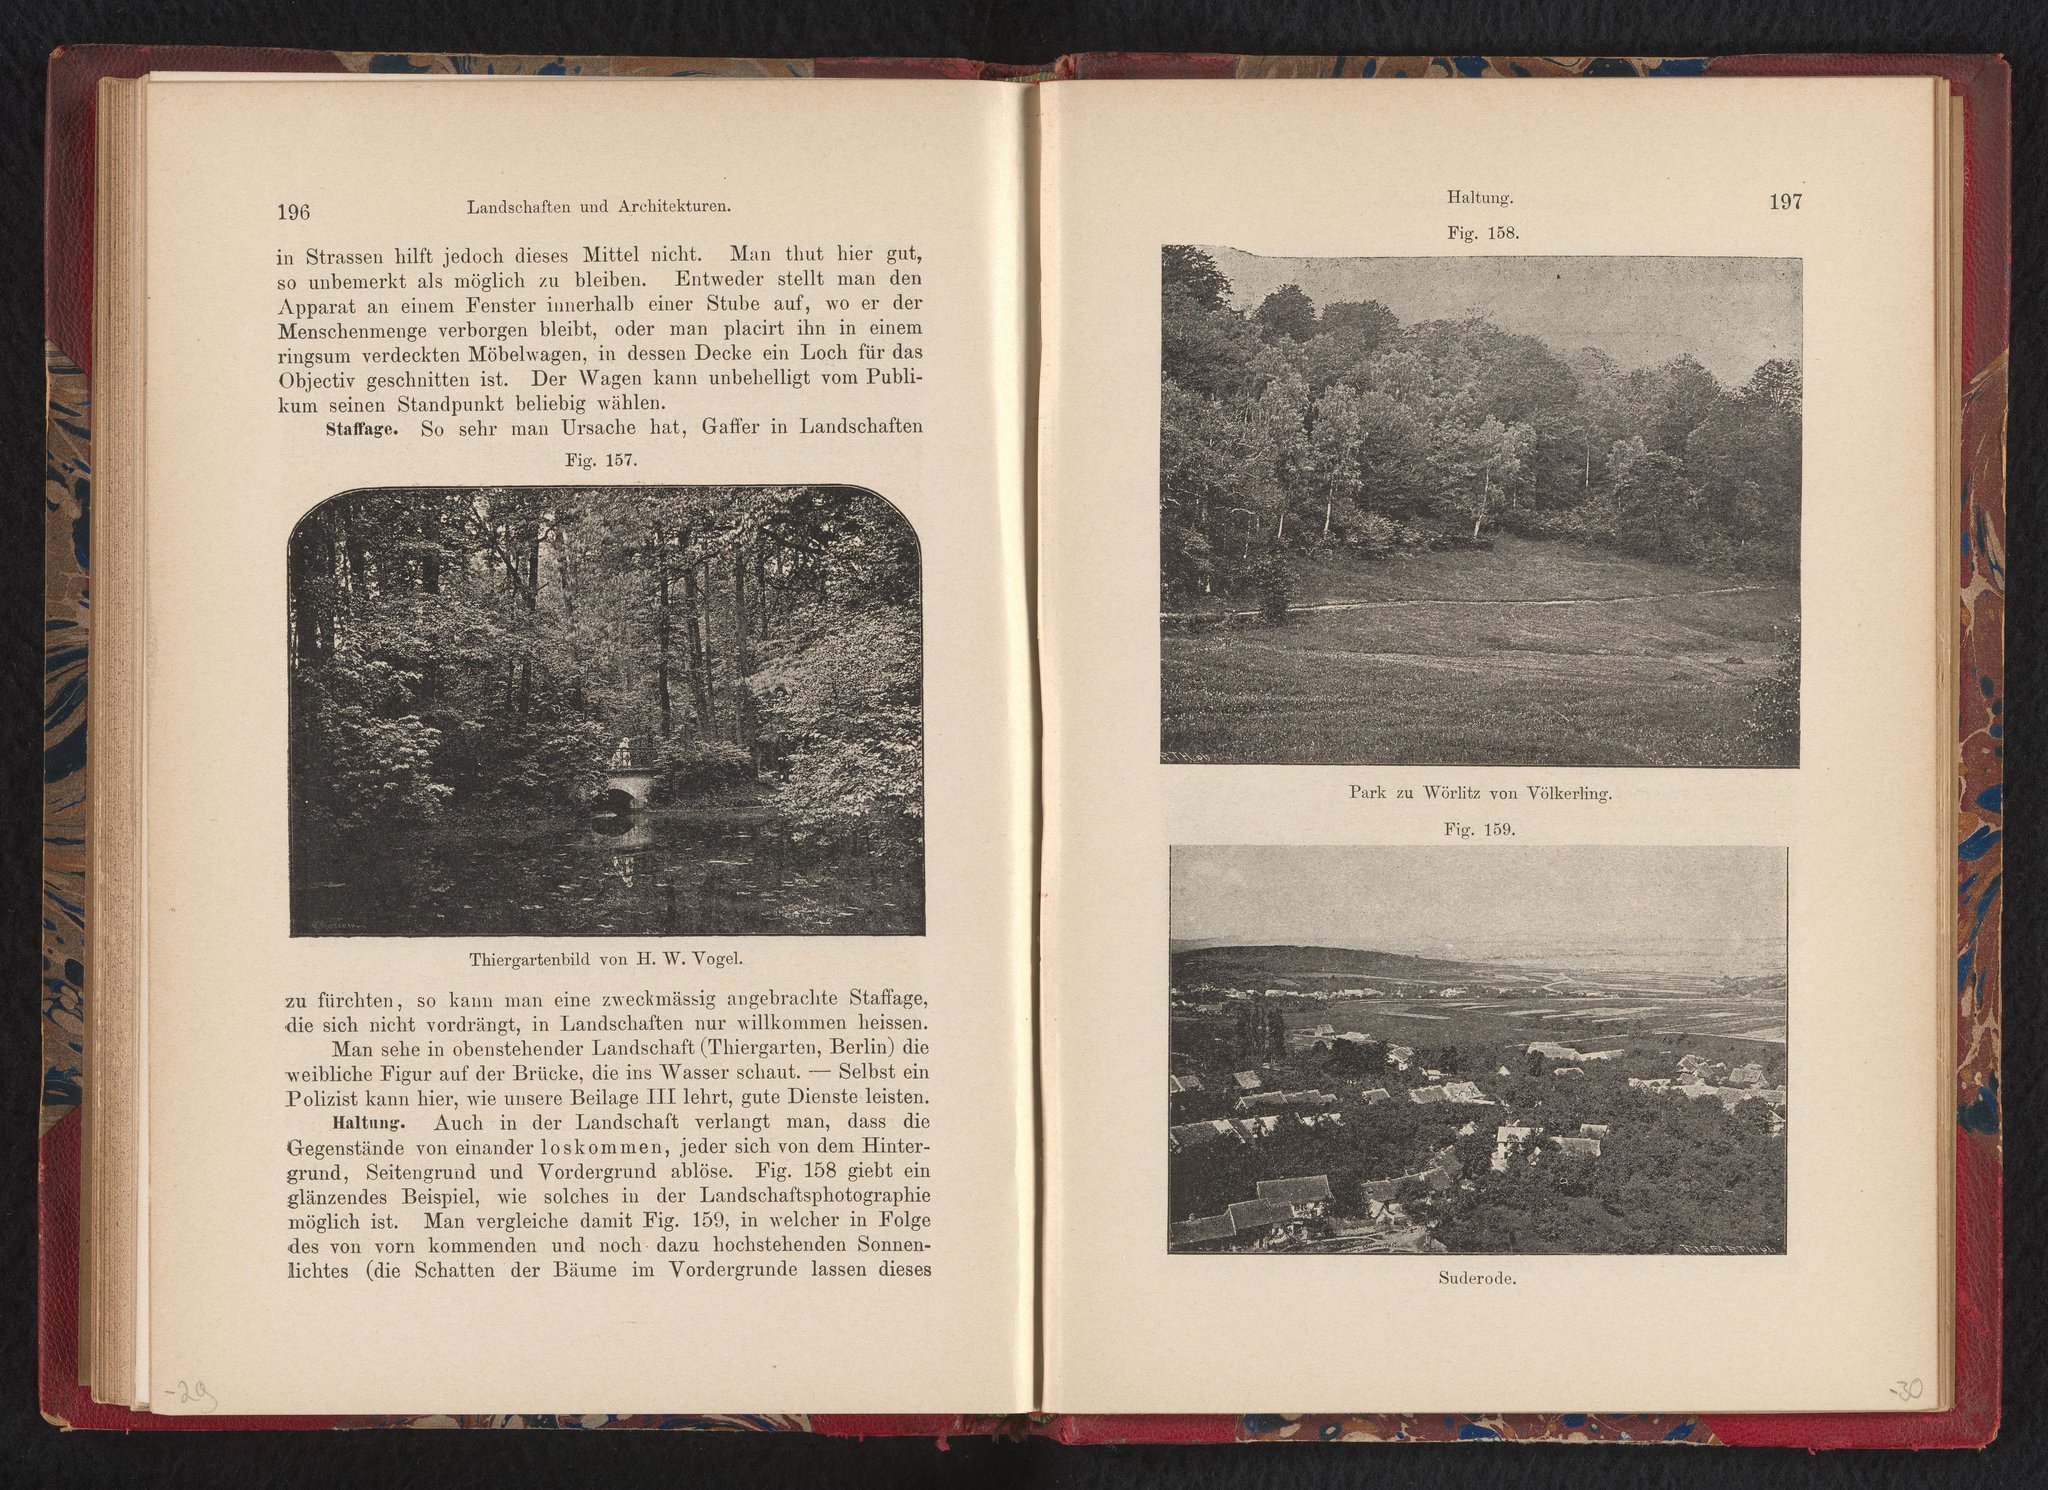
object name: page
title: Gezicht op het Wörlizer Park en Suderode in Duitsland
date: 1886-1891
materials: paper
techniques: autotype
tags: landscapes, village